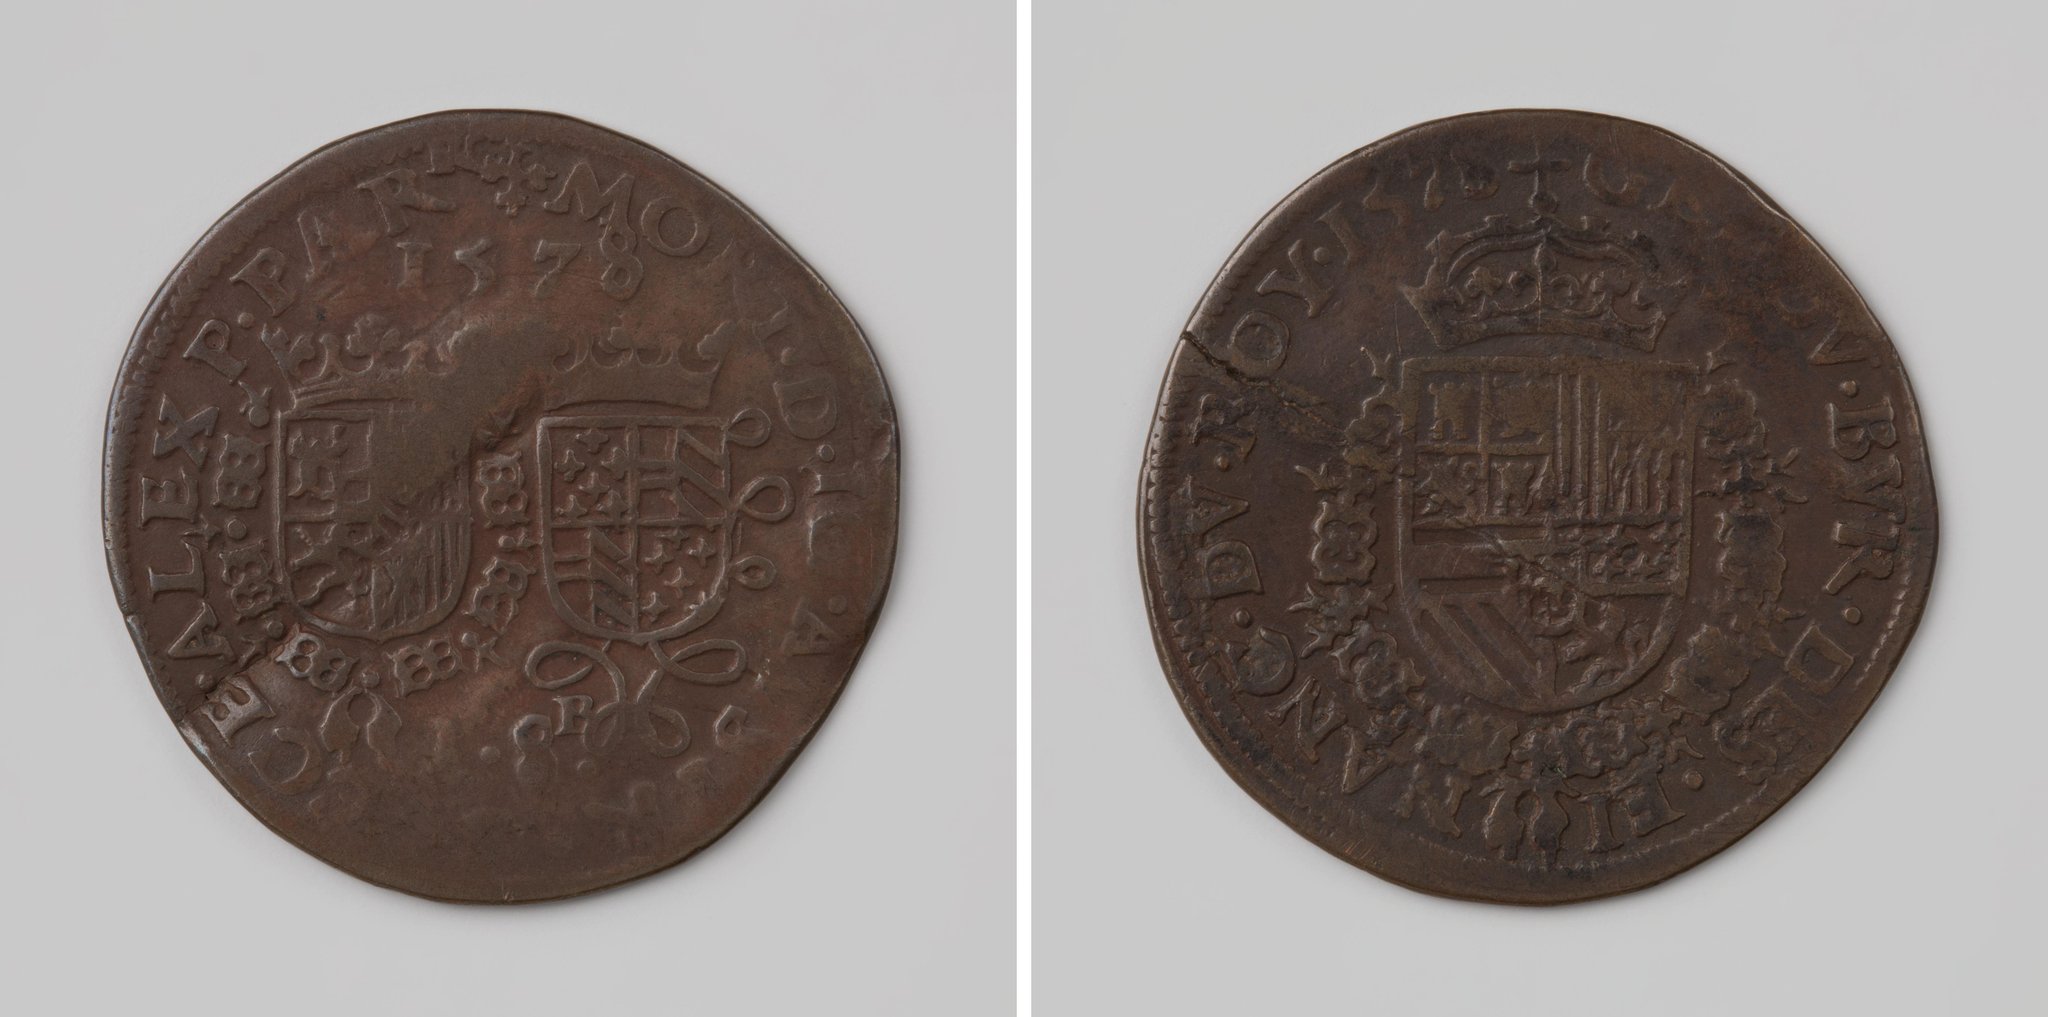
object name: jeton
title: Alessandro Farnese, prins van Parma en Piacenza benoemd tot landvoogd der Nederlanden, rekenpenning van de raad van Financiën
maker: Anonymous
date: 1578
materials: copper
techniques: striking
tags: philip ii of spain, vienna, albert casimir van saksen-teschen, alessandro farnese (landvoogd van de nederlanden en hertog van parma en piacenza), low countries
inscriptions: circumscription: ‘GECT DV BVR DES FINAN DV ROY 1578’, circumscription: ‘MORT D 10 AVSTR SVCCE ALEX P PAR / 1578 8 B’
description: Koperen penning. Voorzijde: twee gekroonde wapenschilden, waarvan linker is omhangen met de orde van het Gulden Vlies onder jaartal binnen omschrift. Keerzijde: gekroond wapenschild, omhangen met de orde van het Gulden Vlies binnen omschrift.